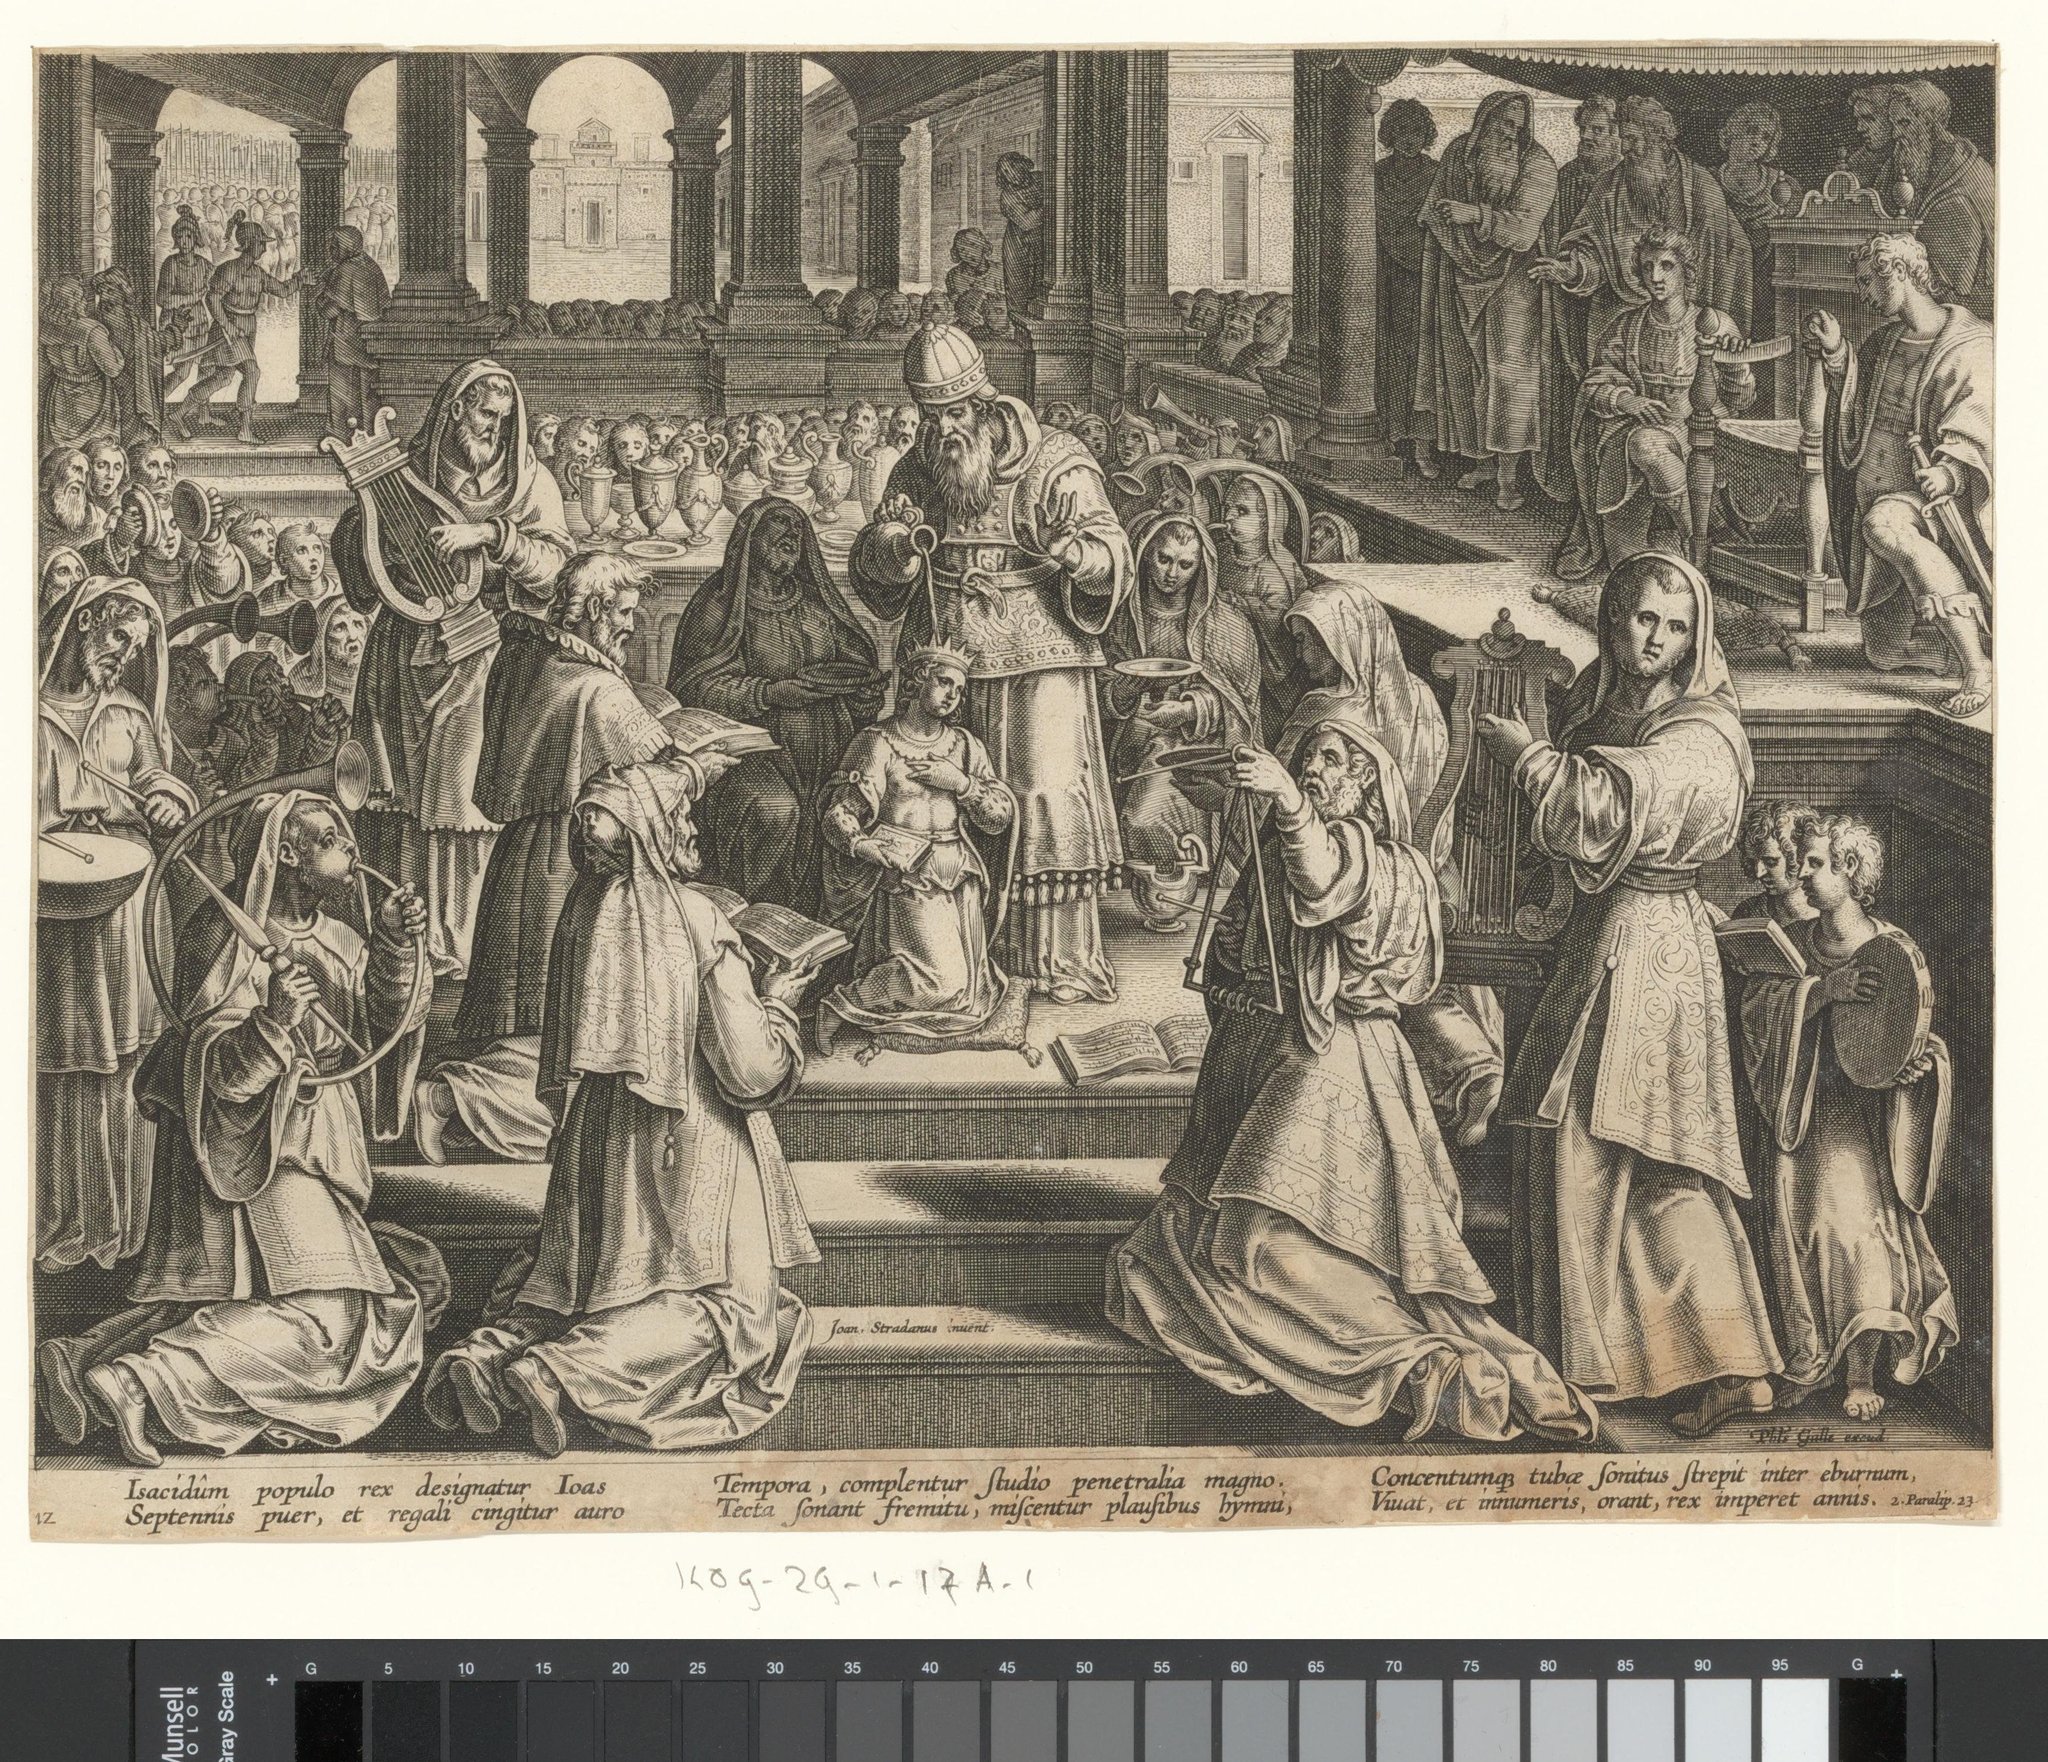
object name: print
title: Joas tot koning gezalfd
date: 1587-1592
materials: paper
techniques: engraving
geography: antwerp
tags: musical instruments; group of musical instruments, joash is proclaimed king at the age of seven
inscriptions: stamp, collector's mark: Lugt 1641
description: In het midden van de tempel zit de jonge Joas geknield voor de priester Jojada die olie over zijn hoofd giet. Zij worden omringd door mannen met muziekinstrumenten (trommel, hoorns, triangel, lier, cimbalen en tamboerijn) en muziekboeken. Onder de prent versregels in het Latijn. Rechtsonder een verwijzing naar 2 Kronieken 23. Linksonder genummerd: 12. Onderwerpsrubrieken binnen de Atlas Zeden en Gewoonten: Muziek en muziekinstrumenten: Muziekinstrumenten op bijbelprenten.